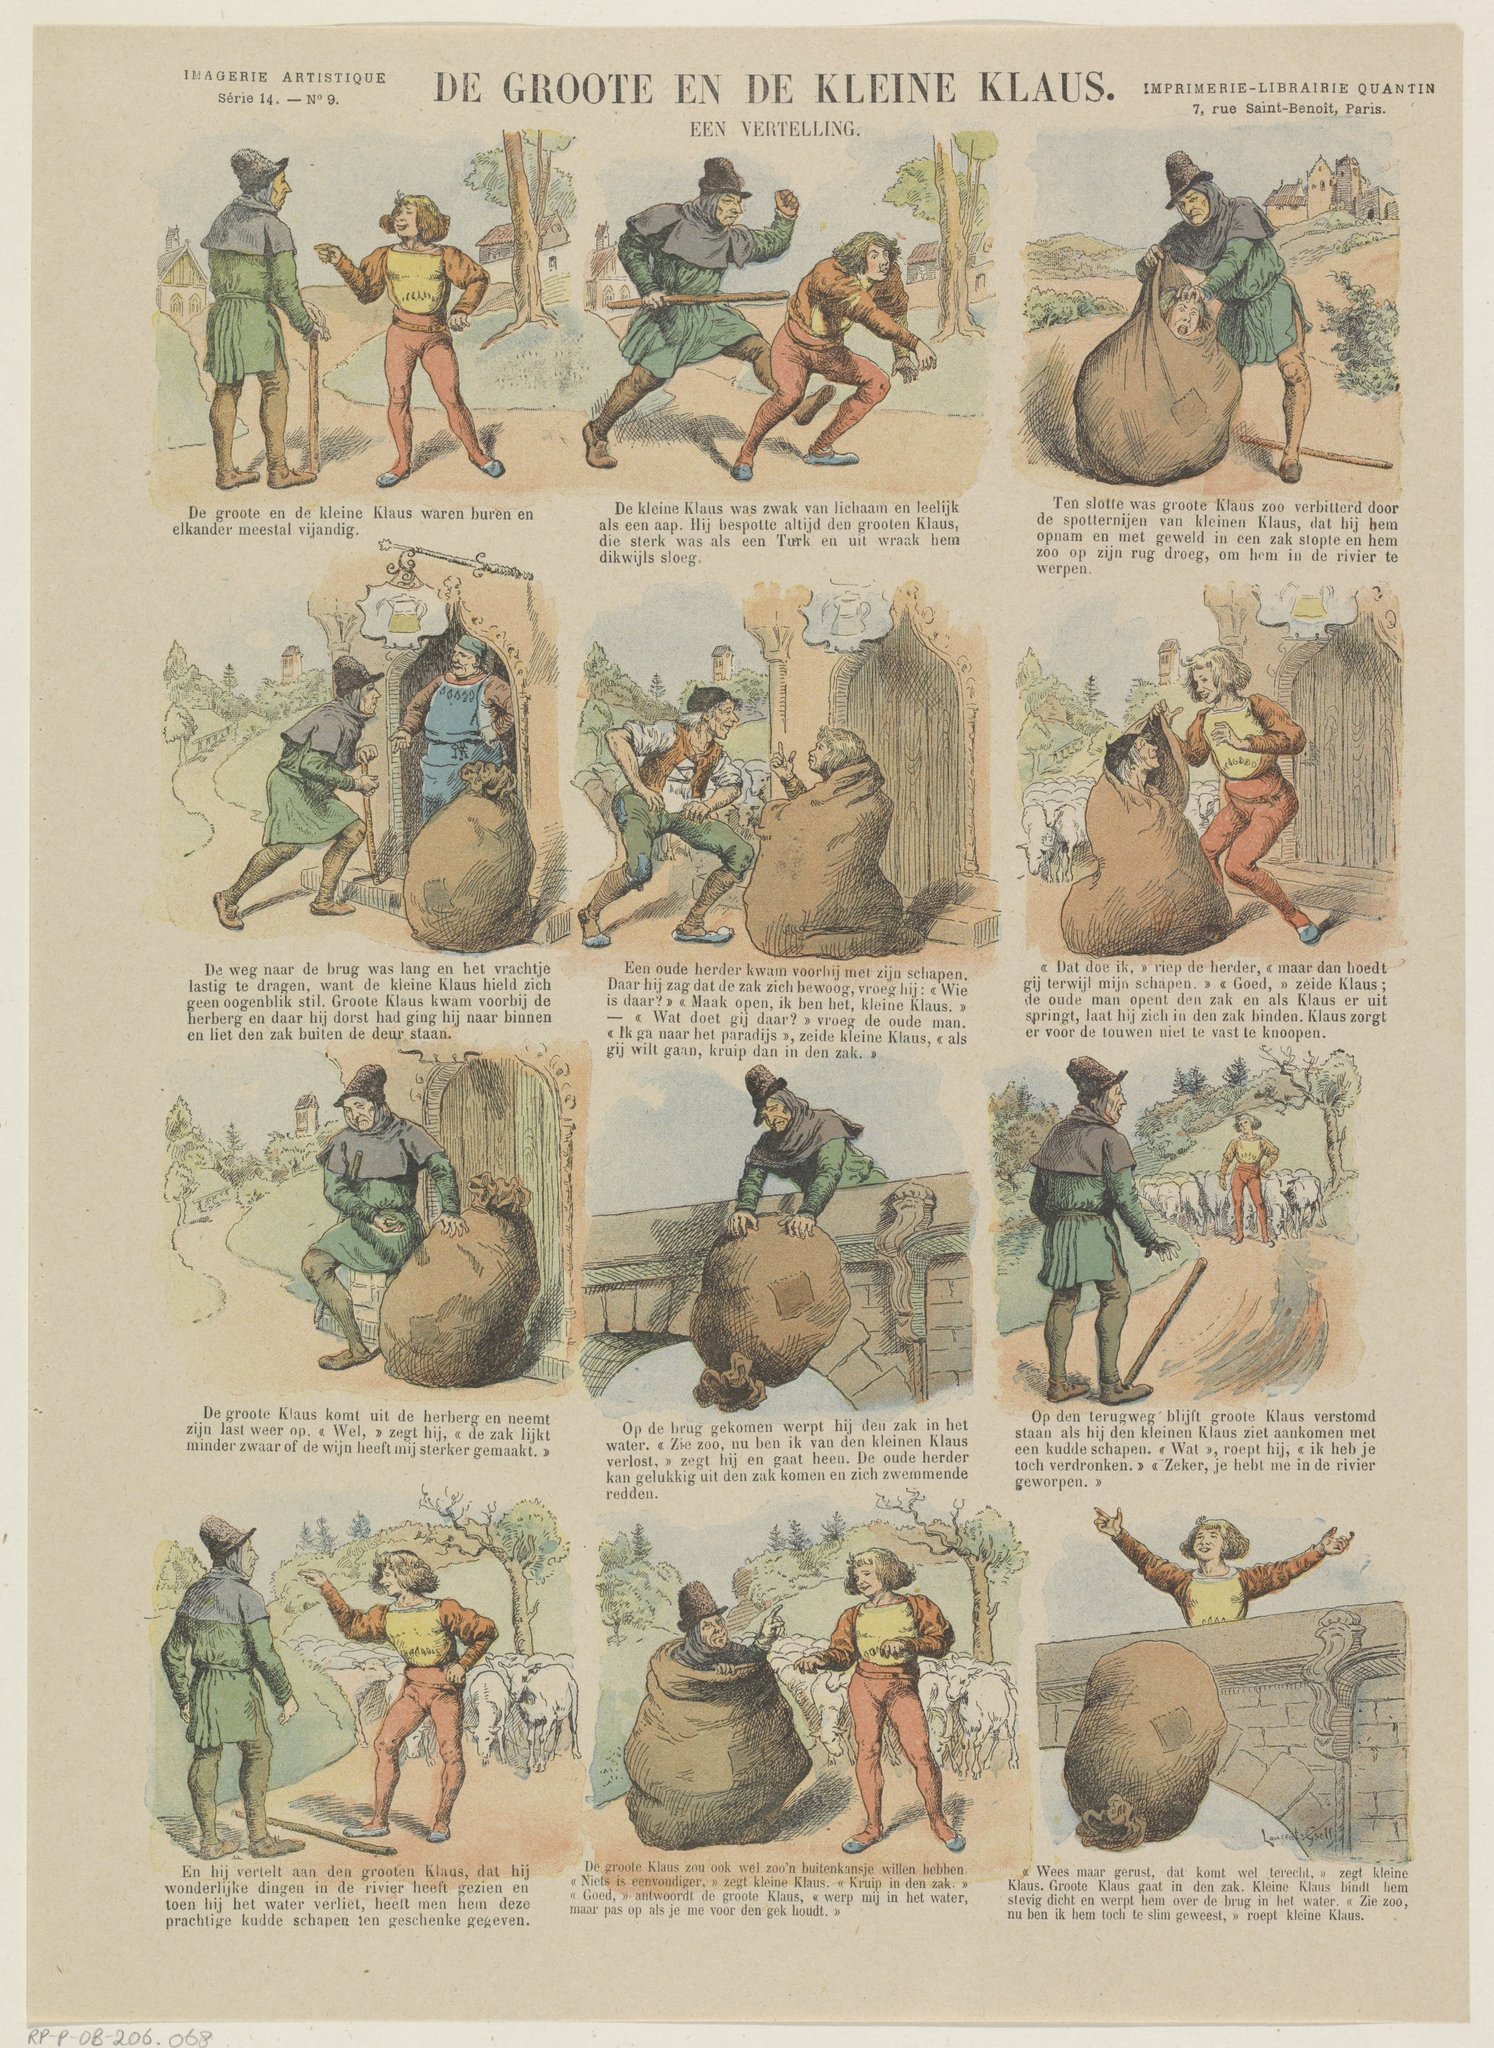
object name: print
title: Imagerie Artistique / Série 14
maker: albert quantin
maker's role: printer, publisher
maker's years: 1850-1933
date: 1876-1890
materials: paper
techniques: lithograph, letterpress printing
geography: paris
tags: herding, herdsman, herdswoman, shepherd, shepherdess, cowherd, etc., bad behaviour, tales and fairy tales, cheat, deceit; 'fraude', 'inganno' (ripa)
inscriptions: collector's mark: Lugt 2760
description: Blad met 12 voorstellingen van de grote Klaus die de kleine Klaus in een zak stopt. Onder elke afbeelding een onderschrift. Genummerd linksboven: Série 14. - No. 9.